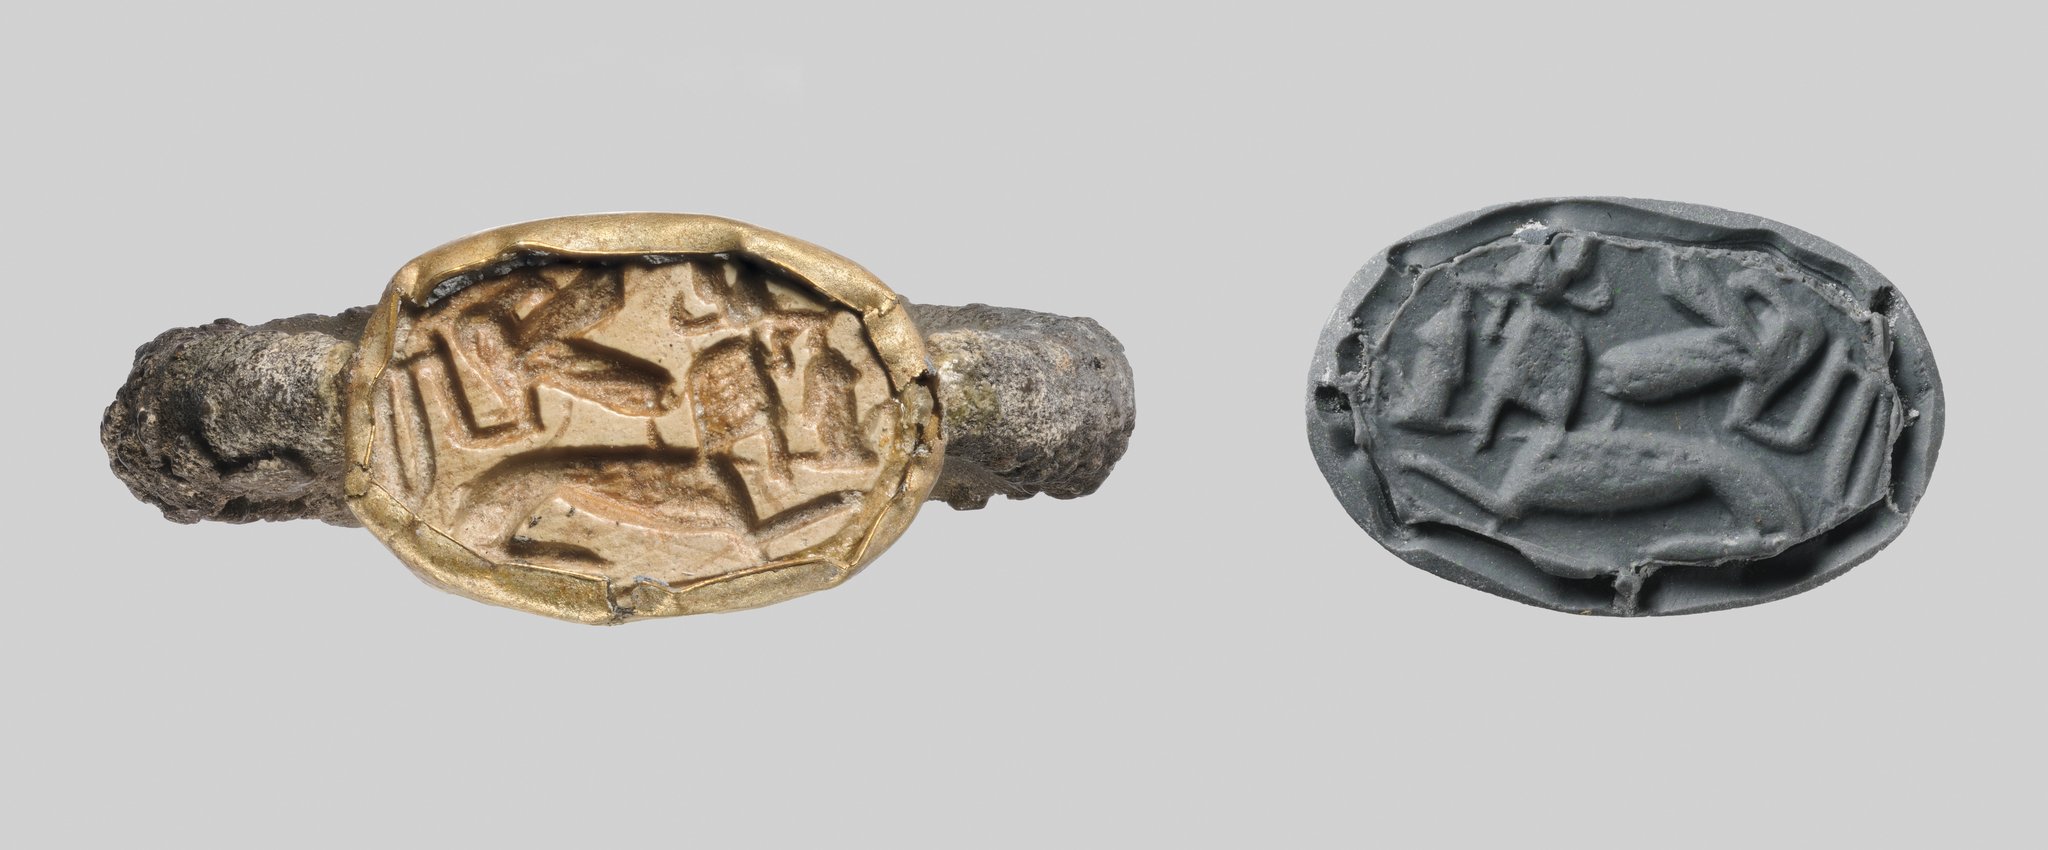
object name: ring with scarab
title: Silver ring with scarab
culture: egyptian or levantine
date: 1090-900 BCE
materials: gold, silver, stone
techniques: glazing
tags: birds,sphinx